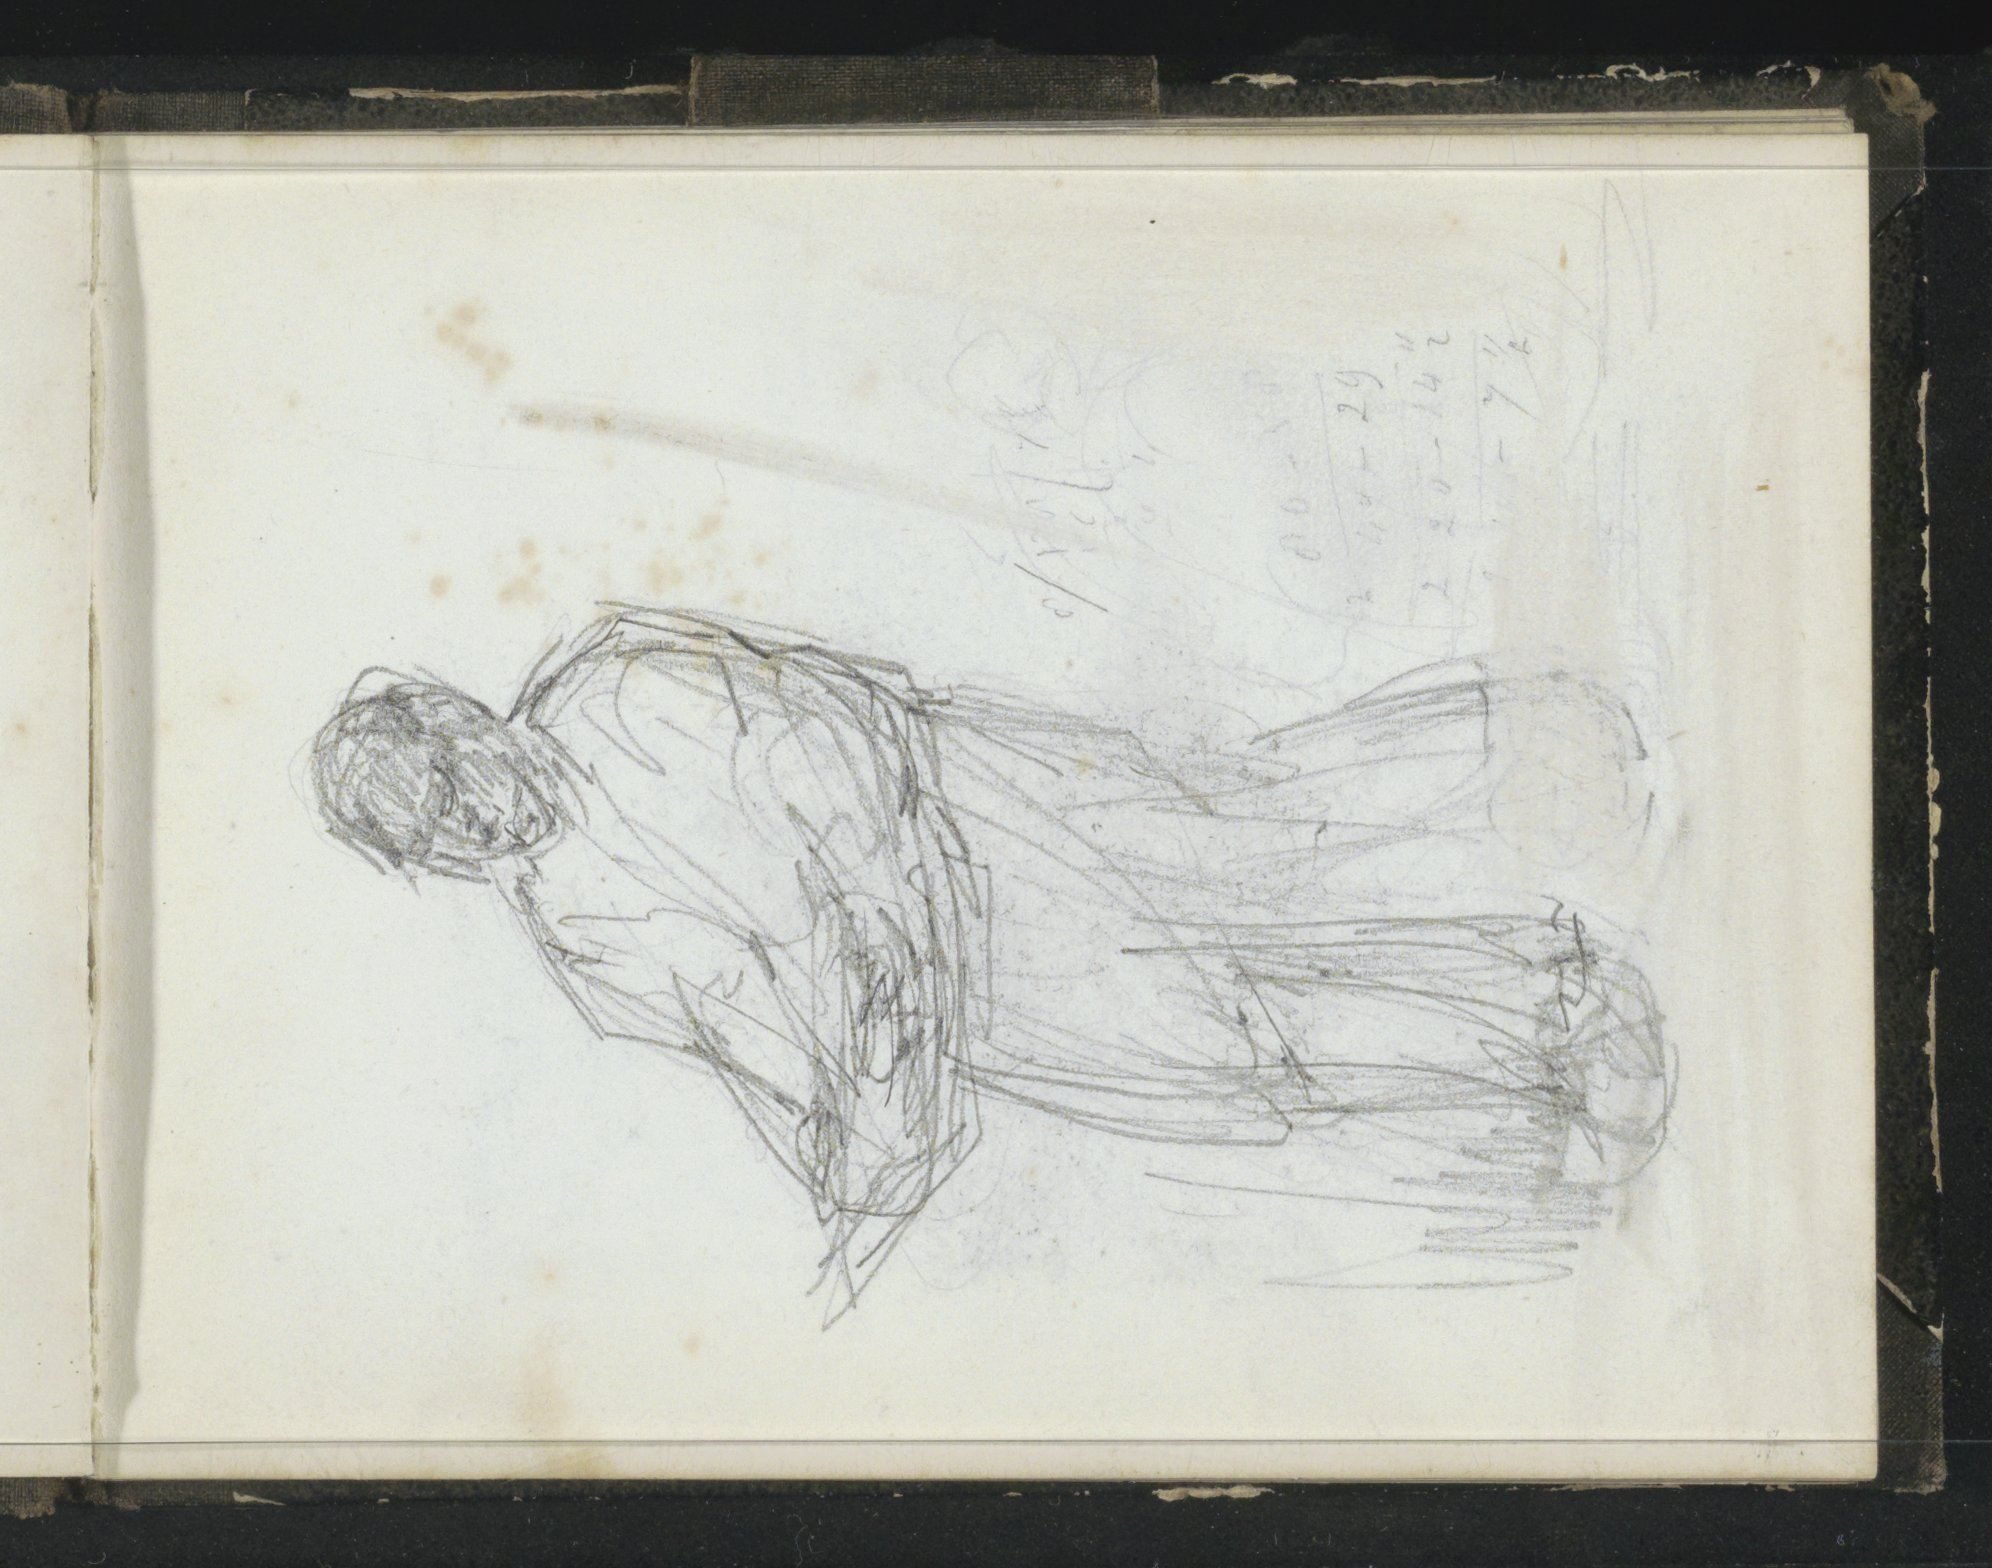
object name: sketchbook leaf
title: Lopende man met een schaal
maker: theo hanrath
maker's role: draughtsman, painter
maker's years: 1853-1883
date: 1879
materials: paper, pencil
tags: carrying something, walking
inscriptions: annotation: ‘[...]’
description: Blad 6 recto uit een schetsboek met 27 bladen.